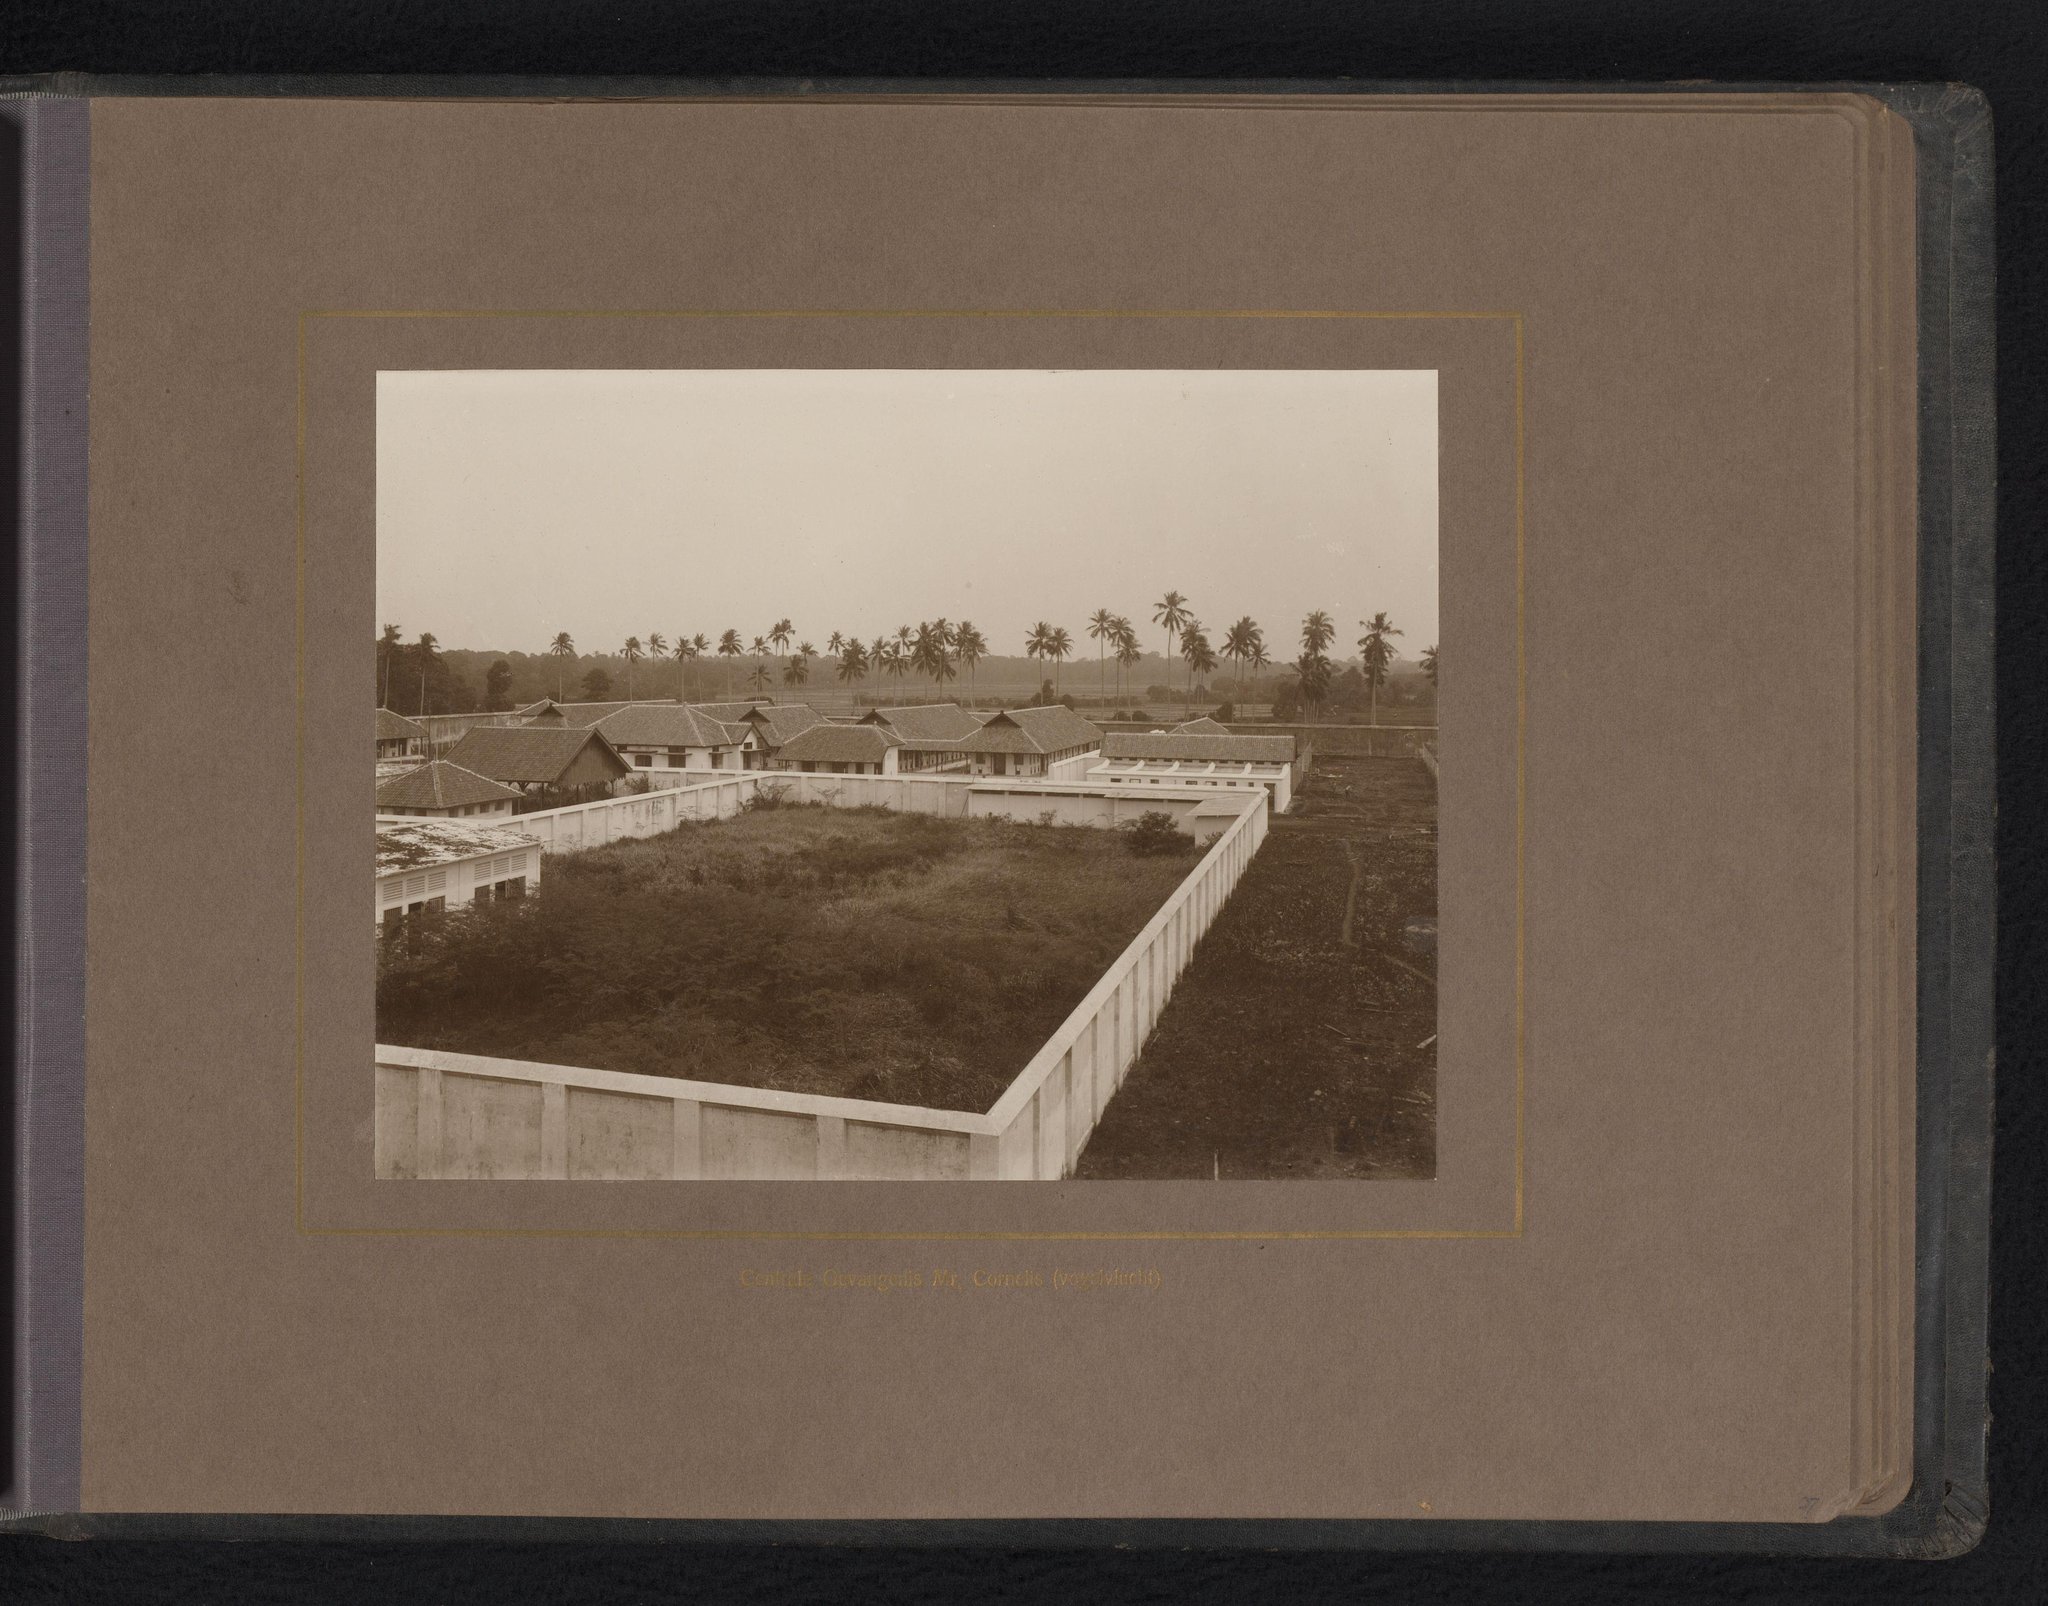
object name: photograph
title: Centrale Gevangenis Mr. Cornelis (vogelvlucht)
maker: Anonymous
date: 1918-1919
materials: photographic support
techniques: gelatin silver print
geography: batavia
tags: prison, jail, batavia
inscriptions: inscription: ‘Centrale Gevangenis Mr. Cornelis (vogelvlucht)’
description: De centrale gevangenis in de wijk Meester Cornelis in Batavia. Gezicht op de gebouwen in vogelvlucht. Onderdeel van het fotoalbum van de Eerste Waterstaatsafdeling op West-Java 22 maart 1915 - 30 juli 1919.